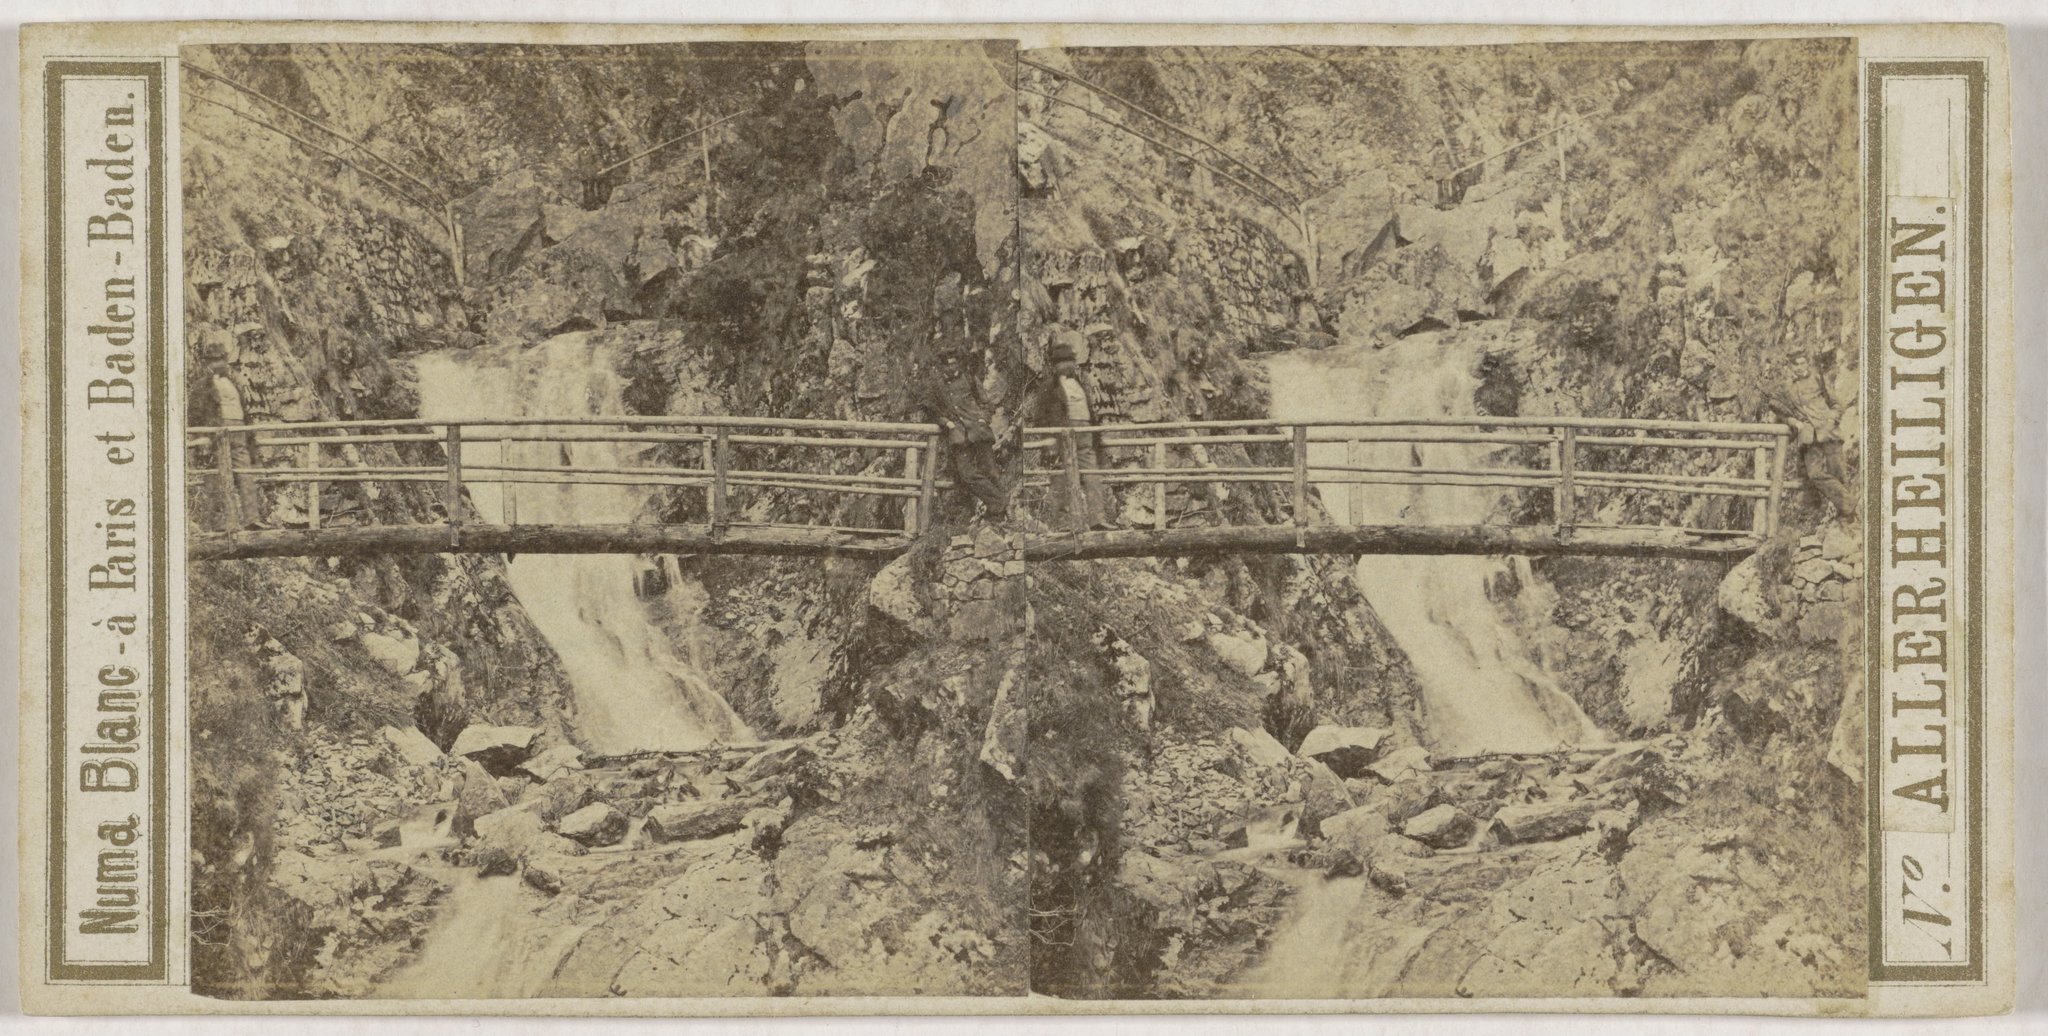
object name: stereograph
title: Allerheiligen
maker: numa blanc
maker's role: publisher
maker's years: 1816-1897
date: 1857-1867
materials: cardboard, paper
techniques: albumen print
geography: oppenau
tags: all saints' day